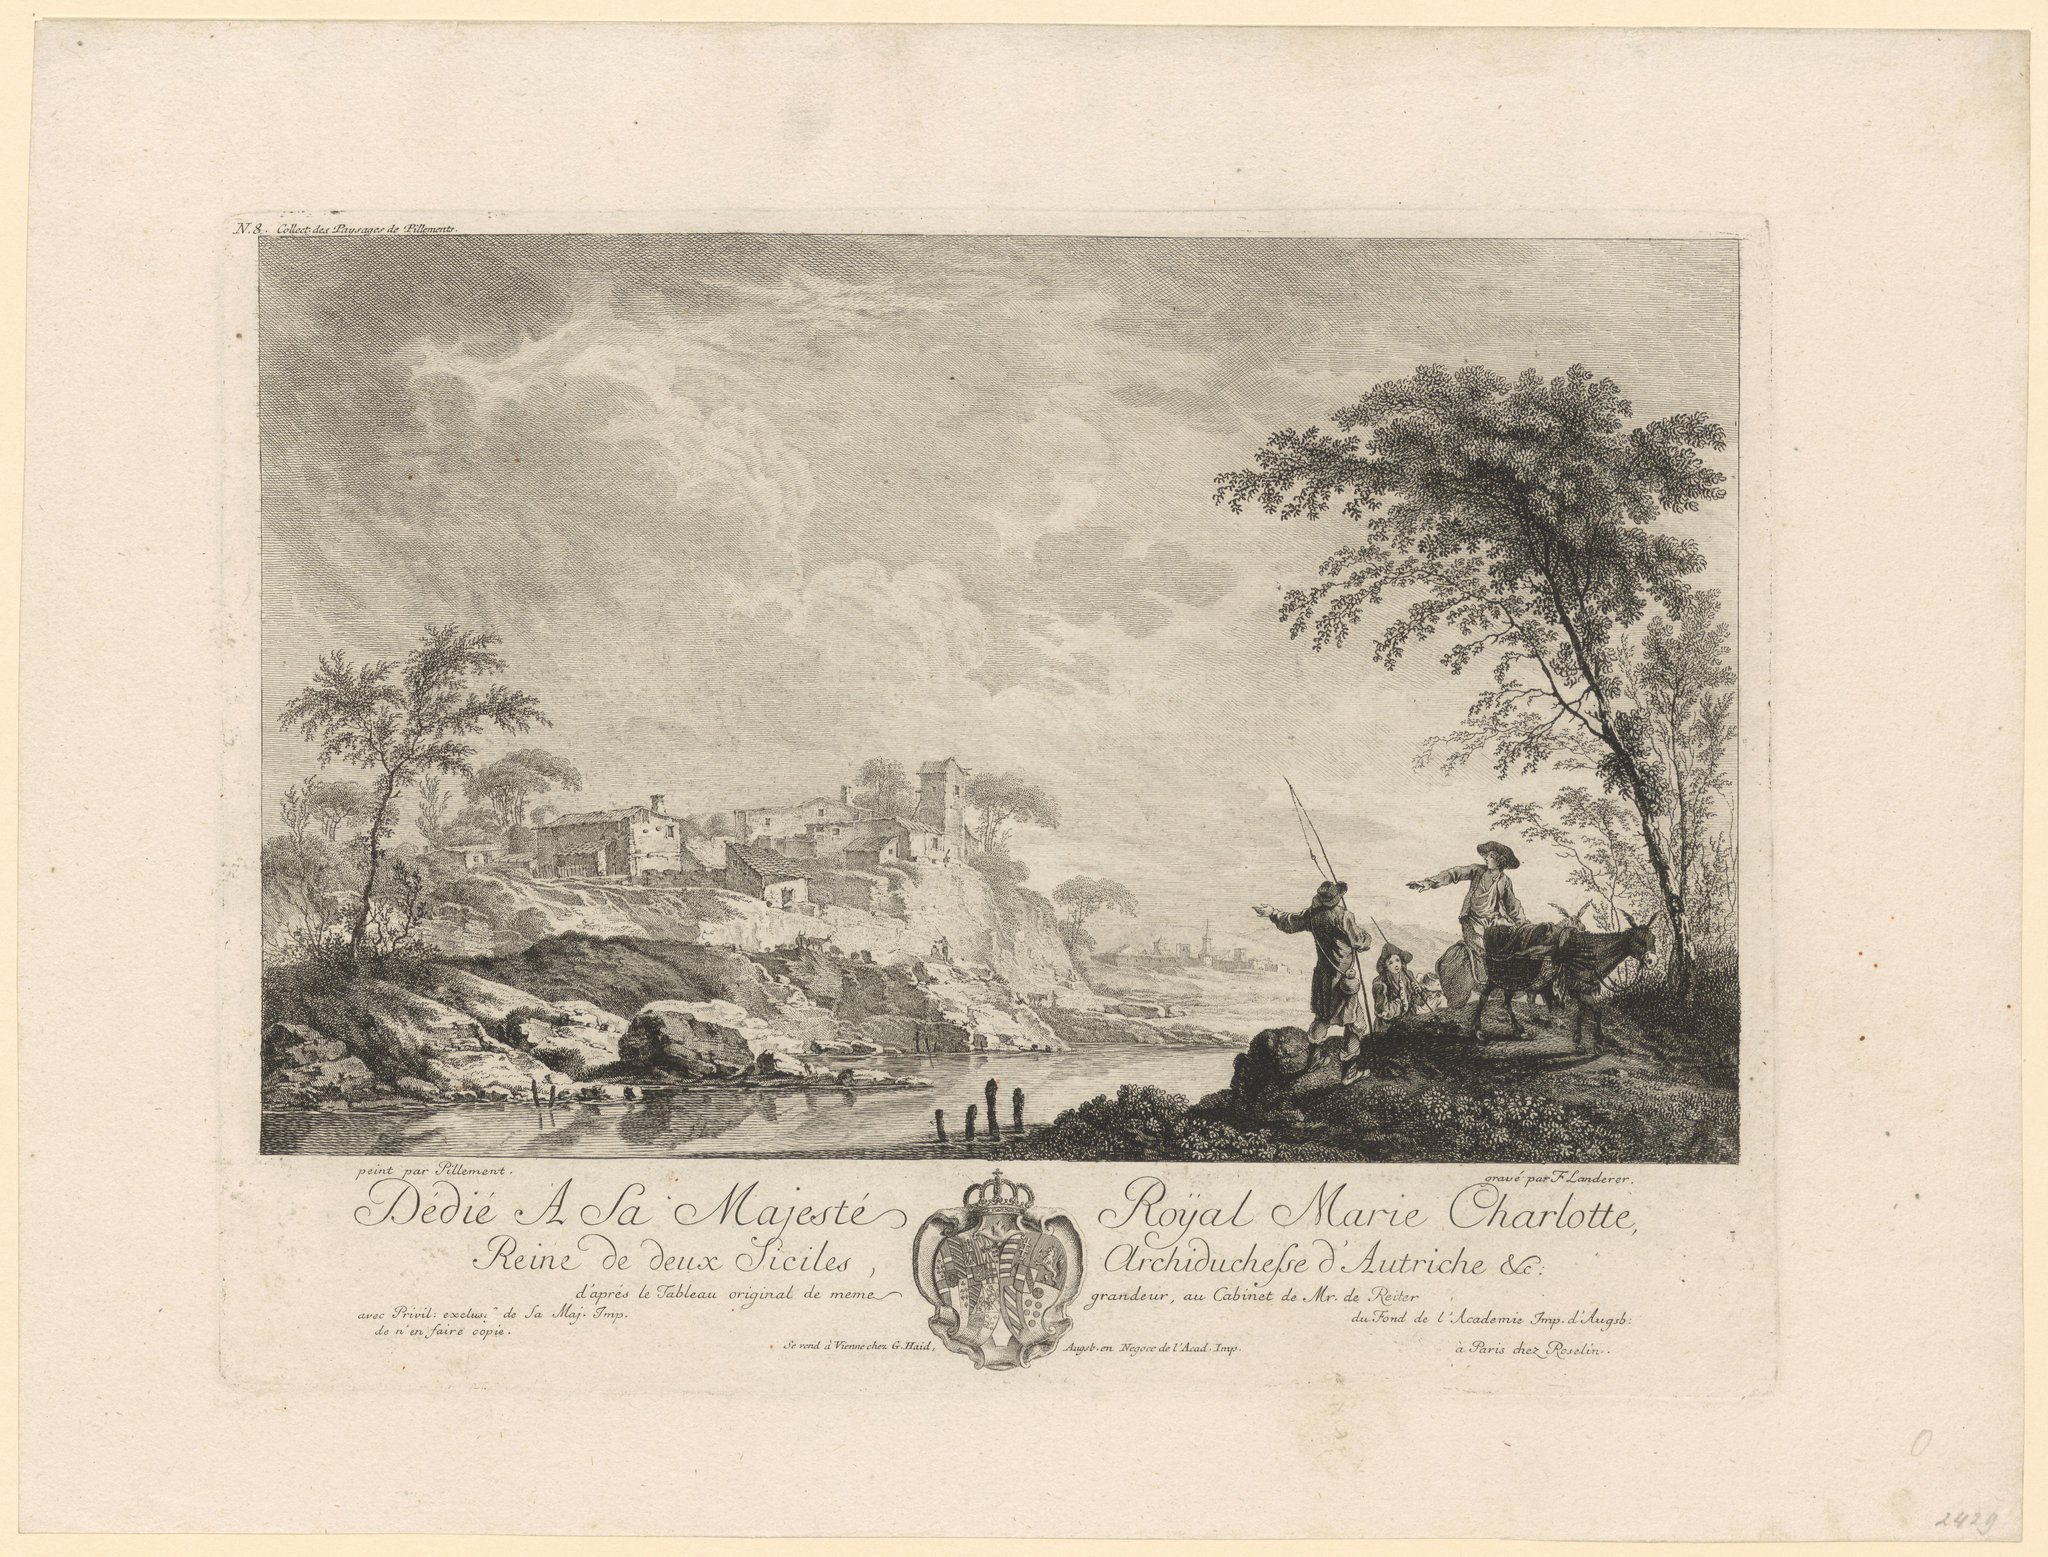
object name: print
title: Heuvellandschap met dorpen en vissers bij een rivier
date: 1763-1764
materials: paper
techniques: etching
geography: paris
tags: low hill country, river, fisherman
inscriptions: collector's mark: Lugt 2760, collector's mark: Lugt 2228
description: Deze prent maakt deel uit van een serie van acht prenten met landschappen.